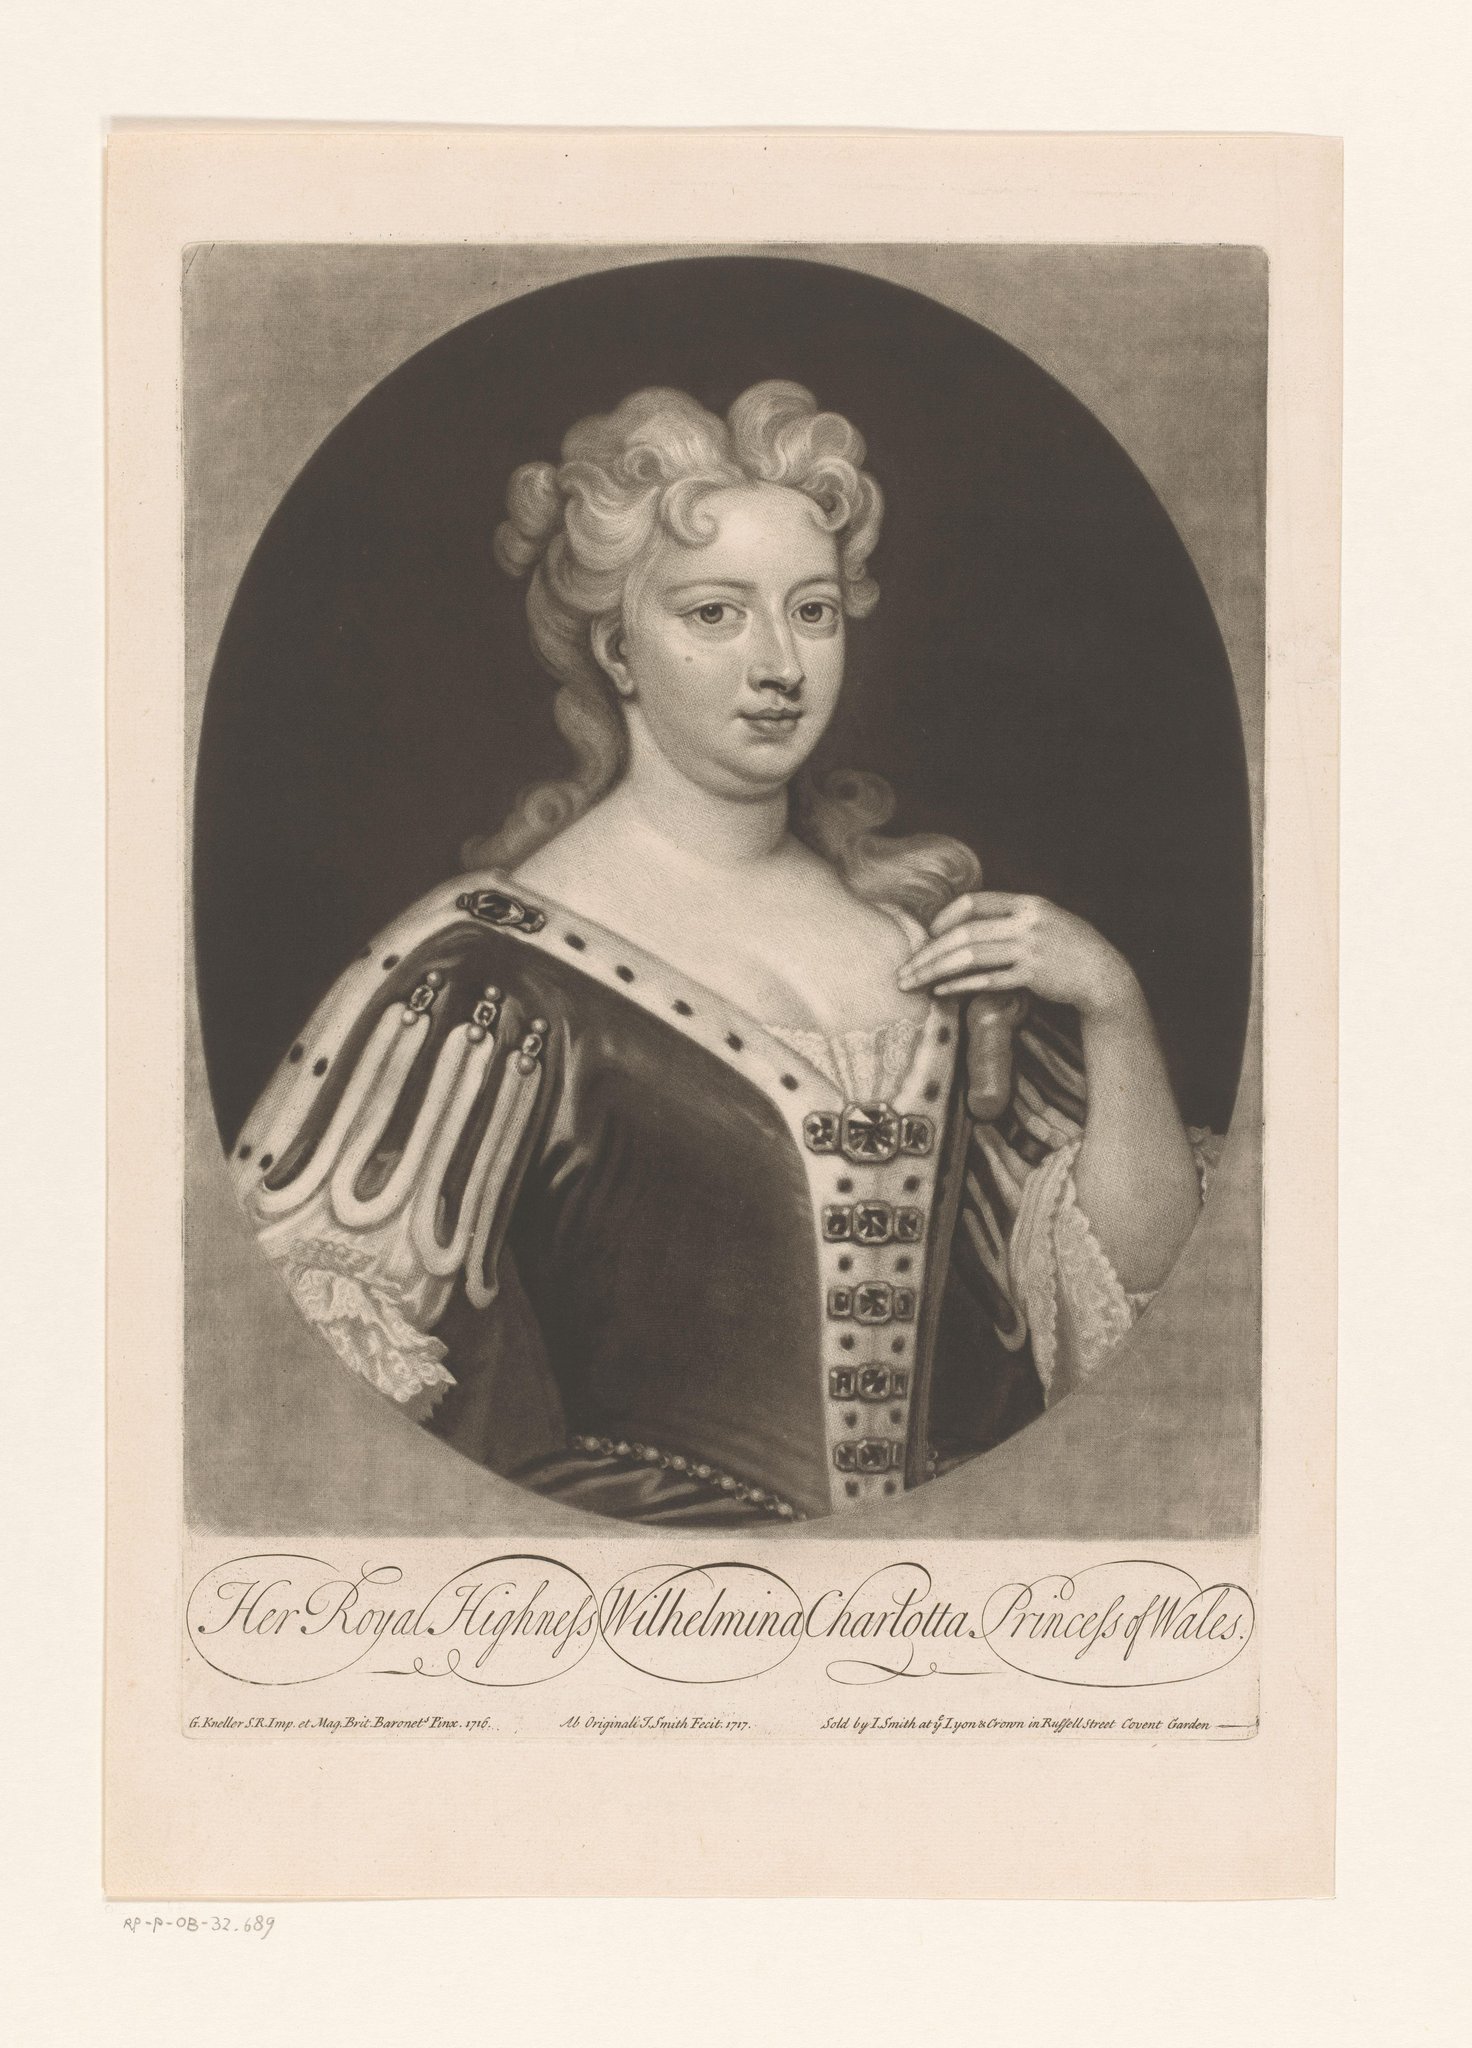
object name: print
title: Portret van Caroline van Ansbach, koningin van Engeland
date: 1716-1717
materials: paper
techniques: mezzotint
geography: london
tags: london, historical persons, queen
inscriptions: collector's mark: Lugt 240